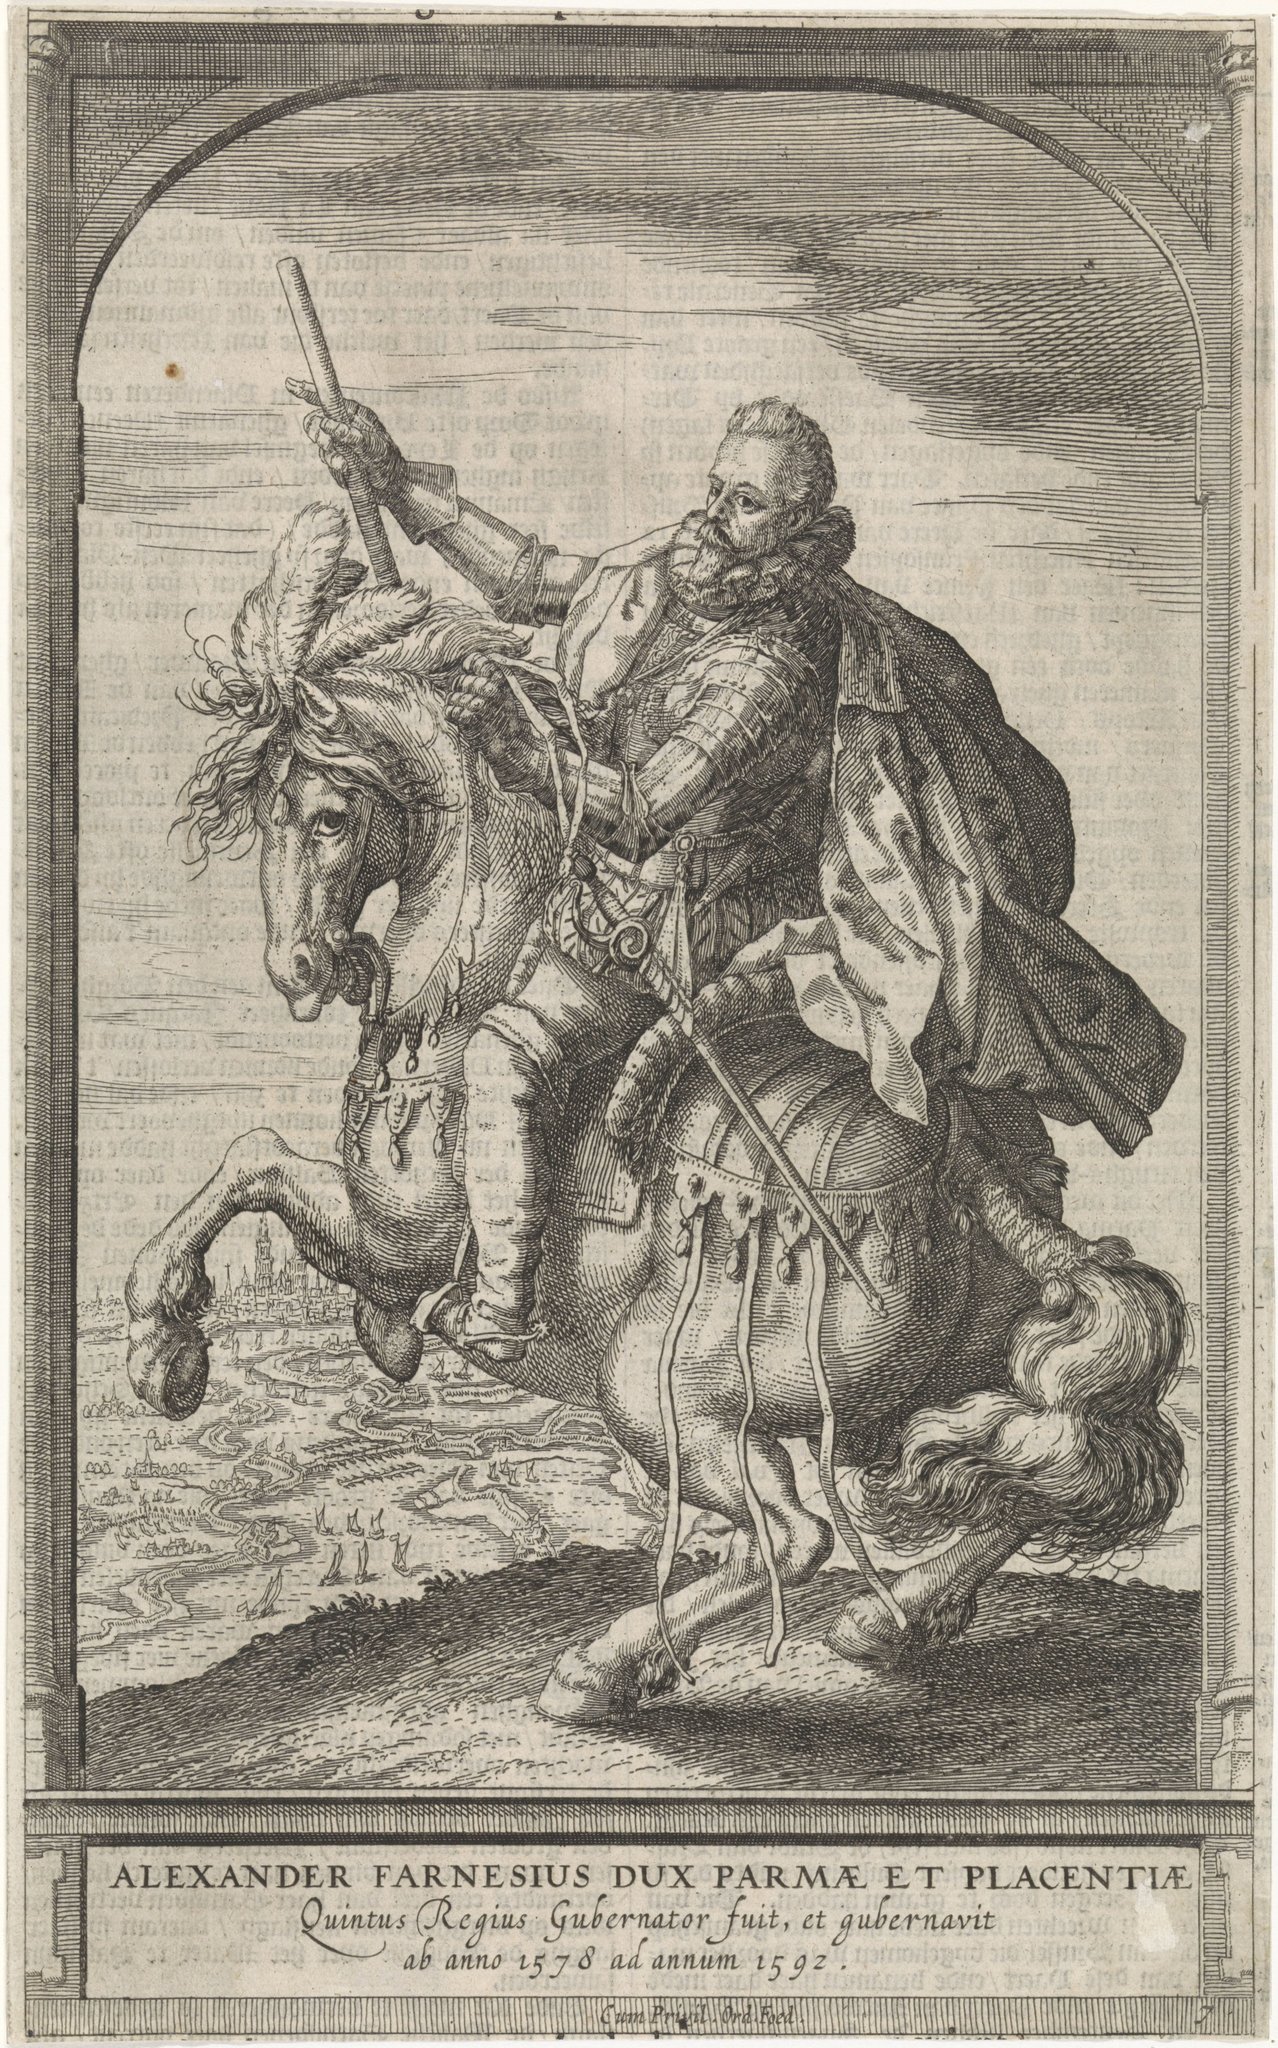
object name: print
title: Alexander Farnesius Dux Parmae et Placentiae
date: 1591-1632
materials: paper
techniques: etching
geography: amsterdam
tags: rome, alessandro farnese (landvoogd van de nederlanden en hertog van parma en piacenza), riding a horse, ass, or mule; rider, horseman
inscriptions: collector's mark: Lugt 2228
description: Alessandro Farnese, hertog van Parma, landvoogd van de Nederlanden, te paard. Naar links. Hij heeft een staf in de hand. Op de achtergrond het beleg van Antwerpen. De prent heeft een Latijns onderschrift en maakt deel uit van een serie ruiterportretten van Nederlandse landvoogden.